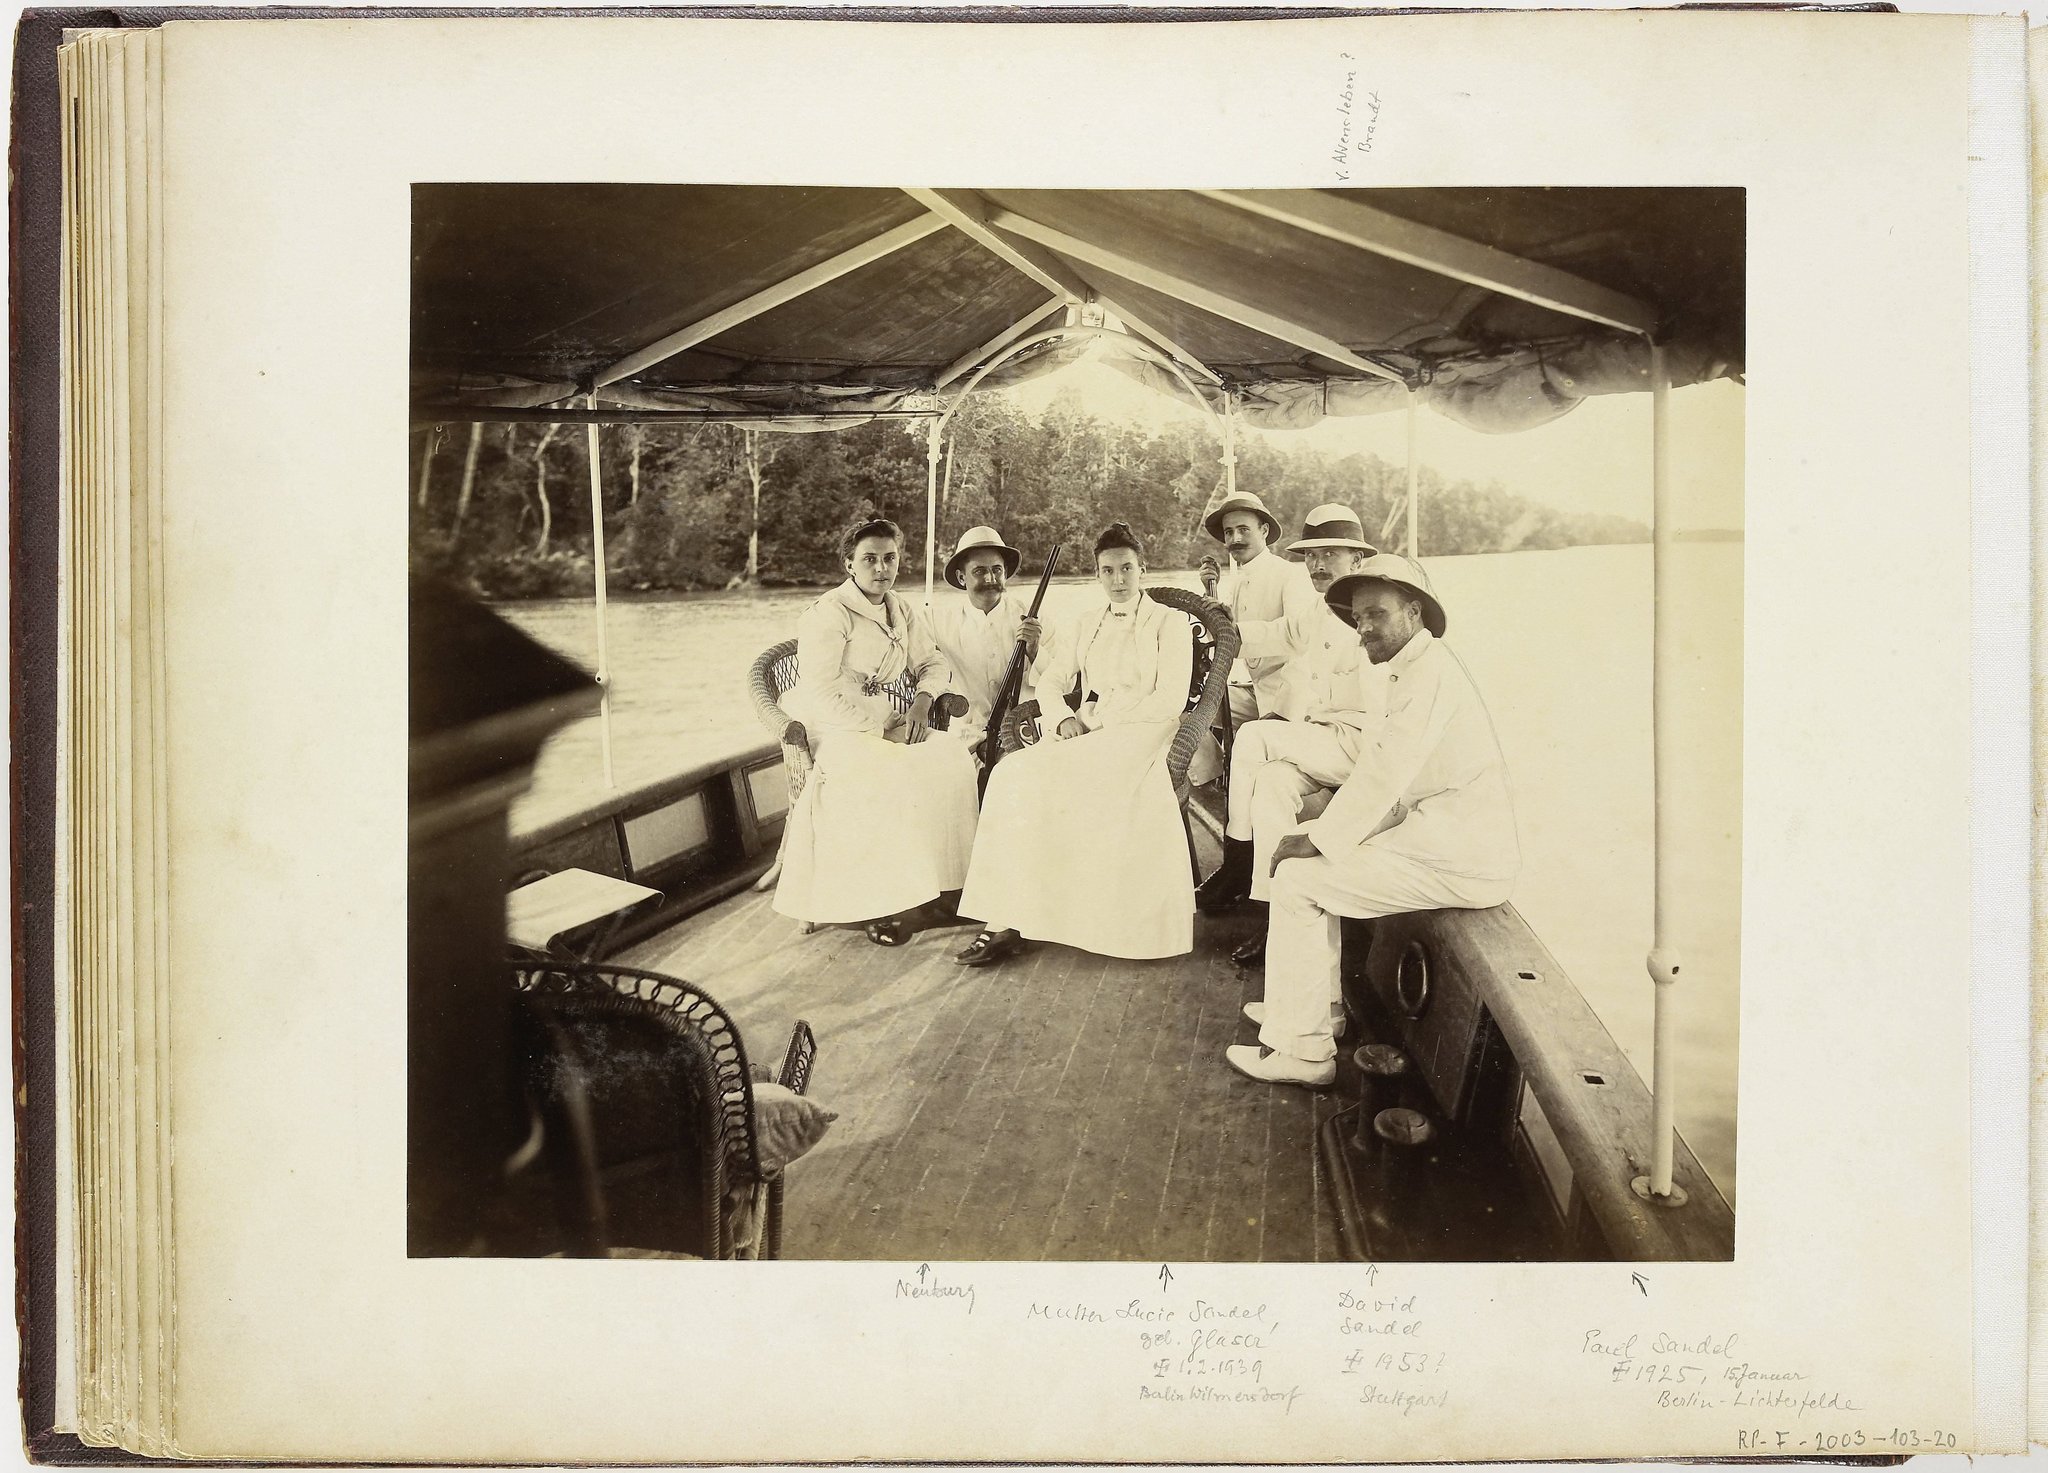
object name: photograph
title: Portret van het gezelschap Sandel in een boot op de Wampoe rivier, Tandjong Poera, Langkat Sumatra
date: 1900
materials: cardboard, paper, photographic support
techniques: albumen print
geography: bindjai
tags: sumatra